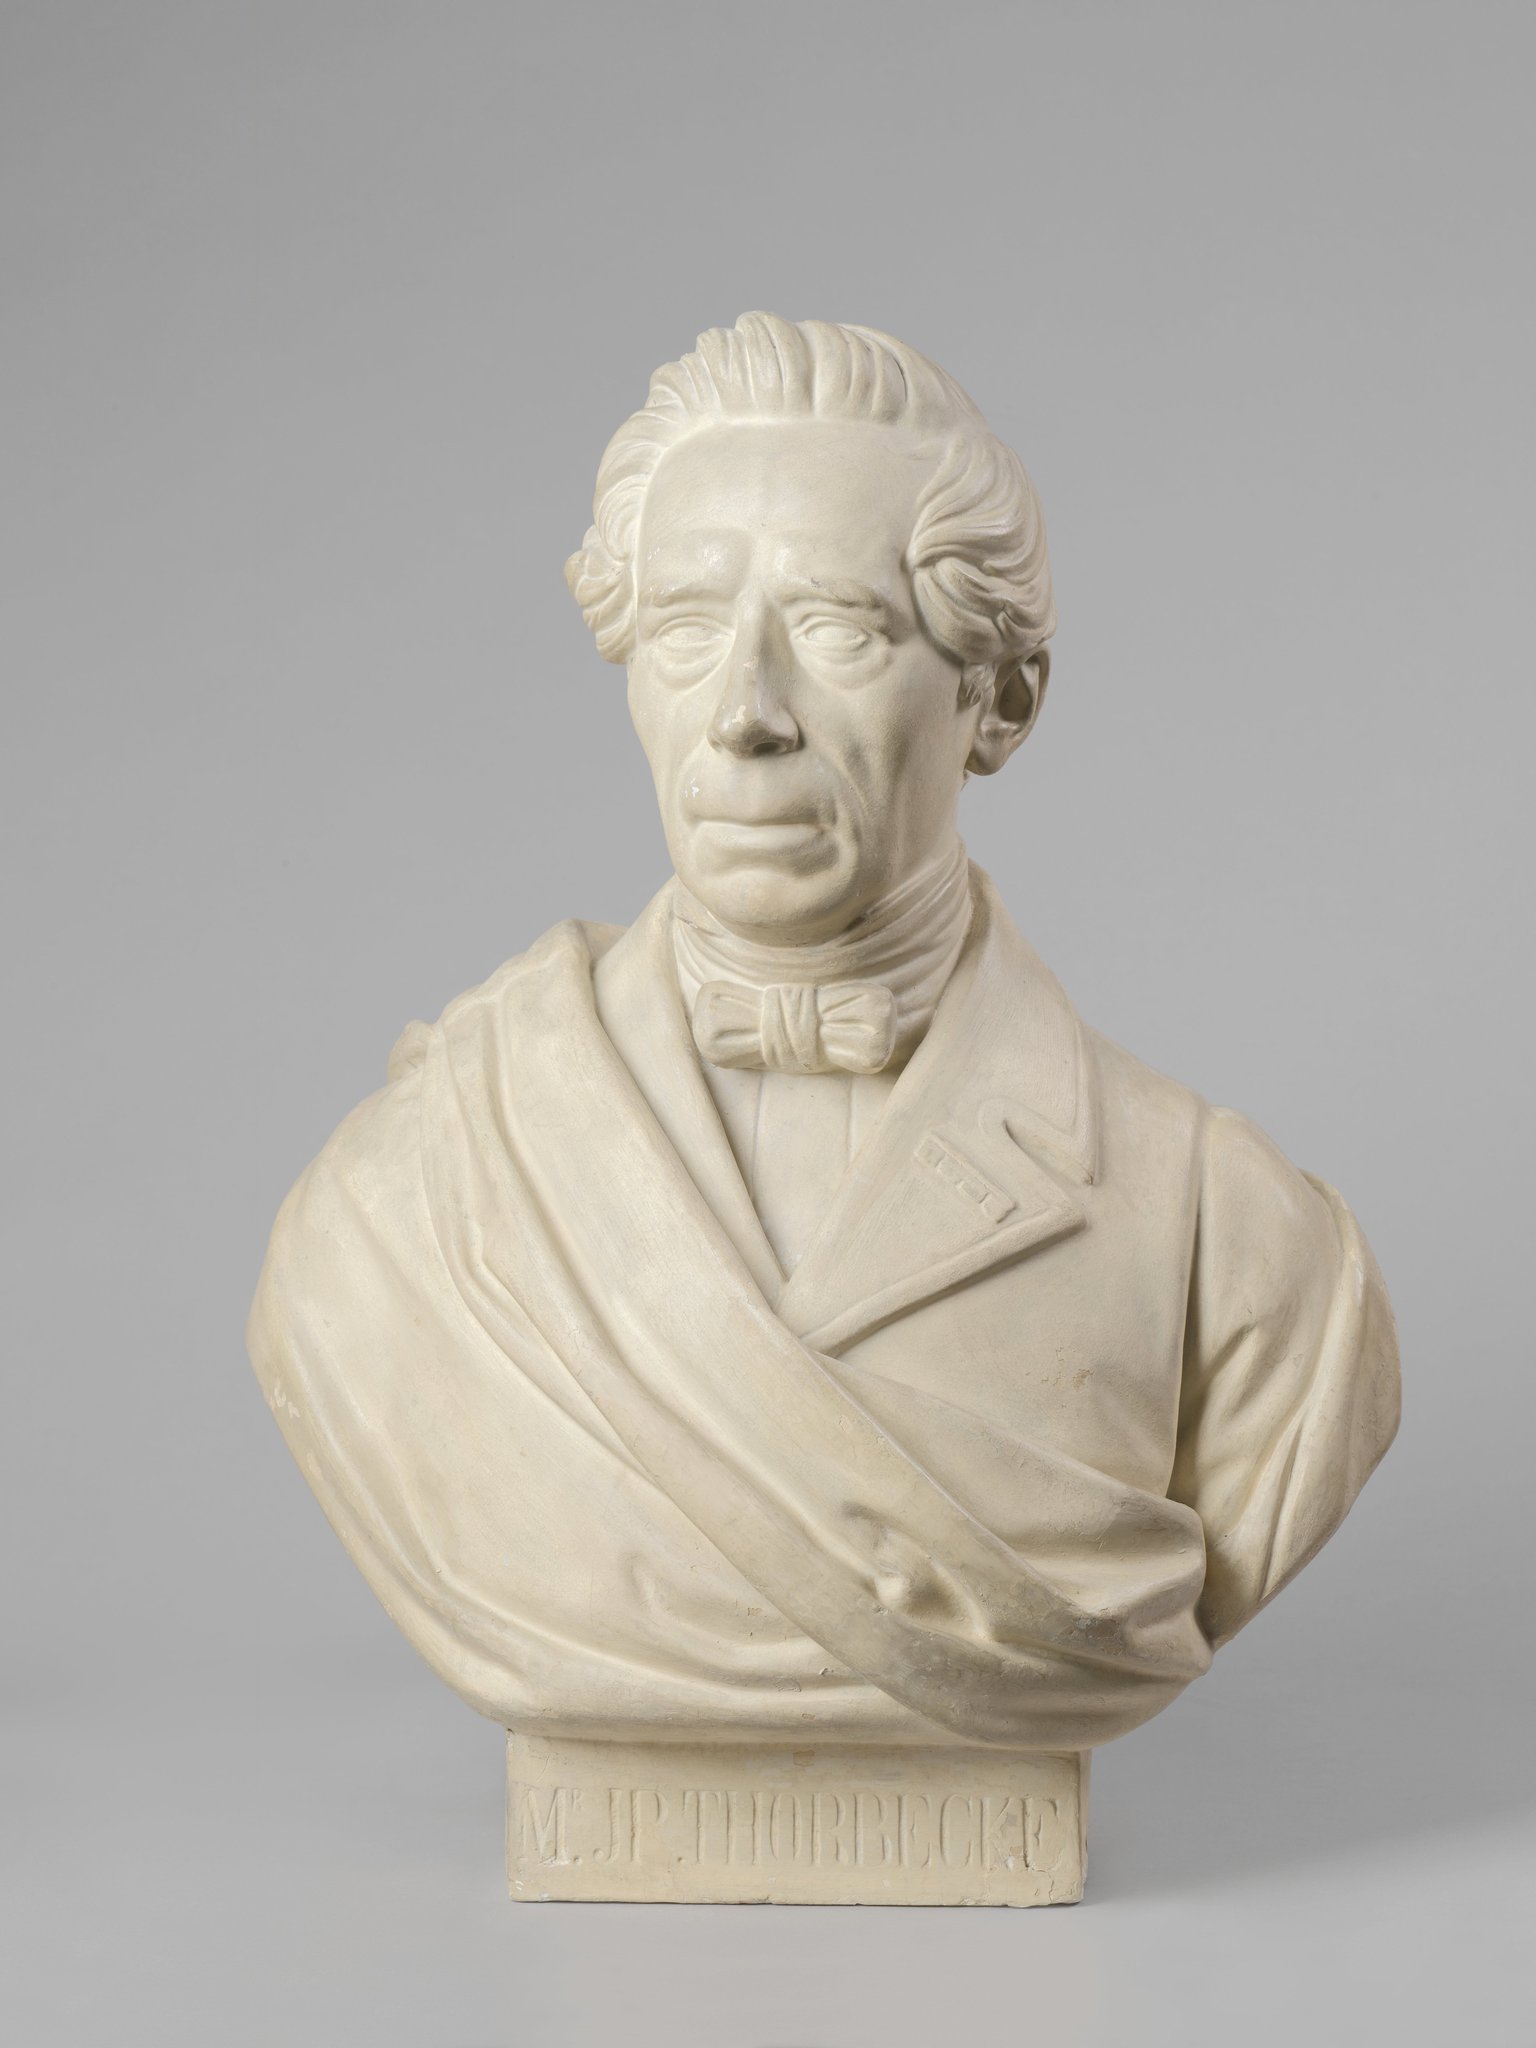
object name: sculpture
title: Borstbeeld van mr. Johan Rudolf Thorbecke (1792-1872)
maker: louis royer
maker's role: draughtsman, sculptor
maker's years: 1793-1868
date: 1866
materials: gypsum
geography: netherlands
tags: johan rudolf thorbecke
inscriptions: inscription: ‘Mr. J.R. Thorbecke’, signature and date: ‘L. Royer 1866’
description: Van het borstbeeld bestaan replieken in brons. In de veilingcatalogus van de collectie Royer van 17-11-1868 worden behalve nog drie afgietsels van het borstbeeld oom de mallen vermeld.